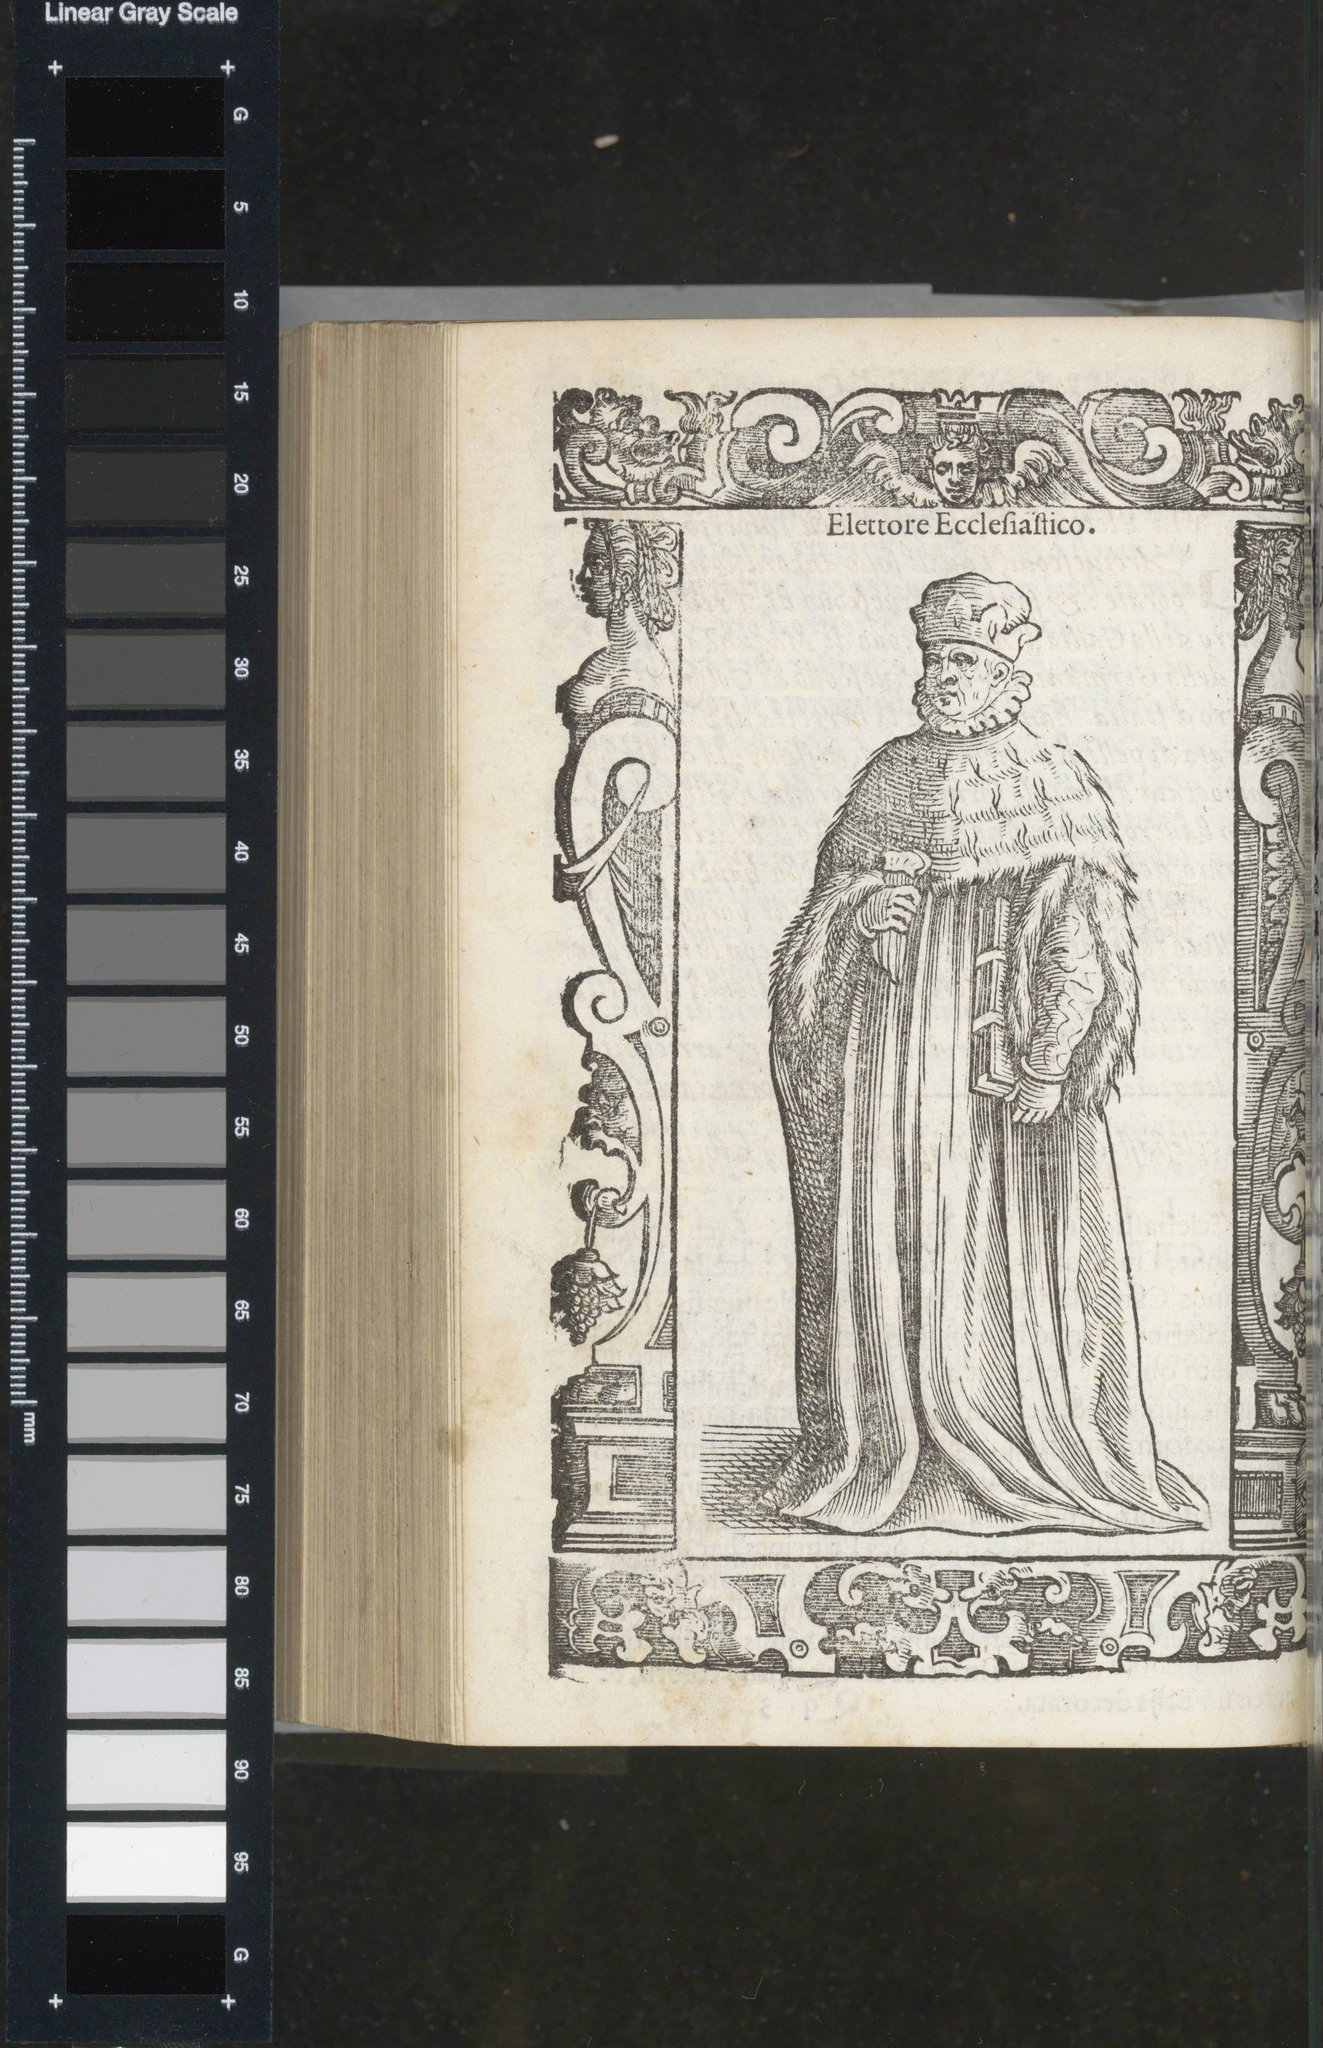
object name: costume print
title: Elettore Ecclesiastico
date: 1598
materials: paper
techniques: woodcut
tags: fashion plates